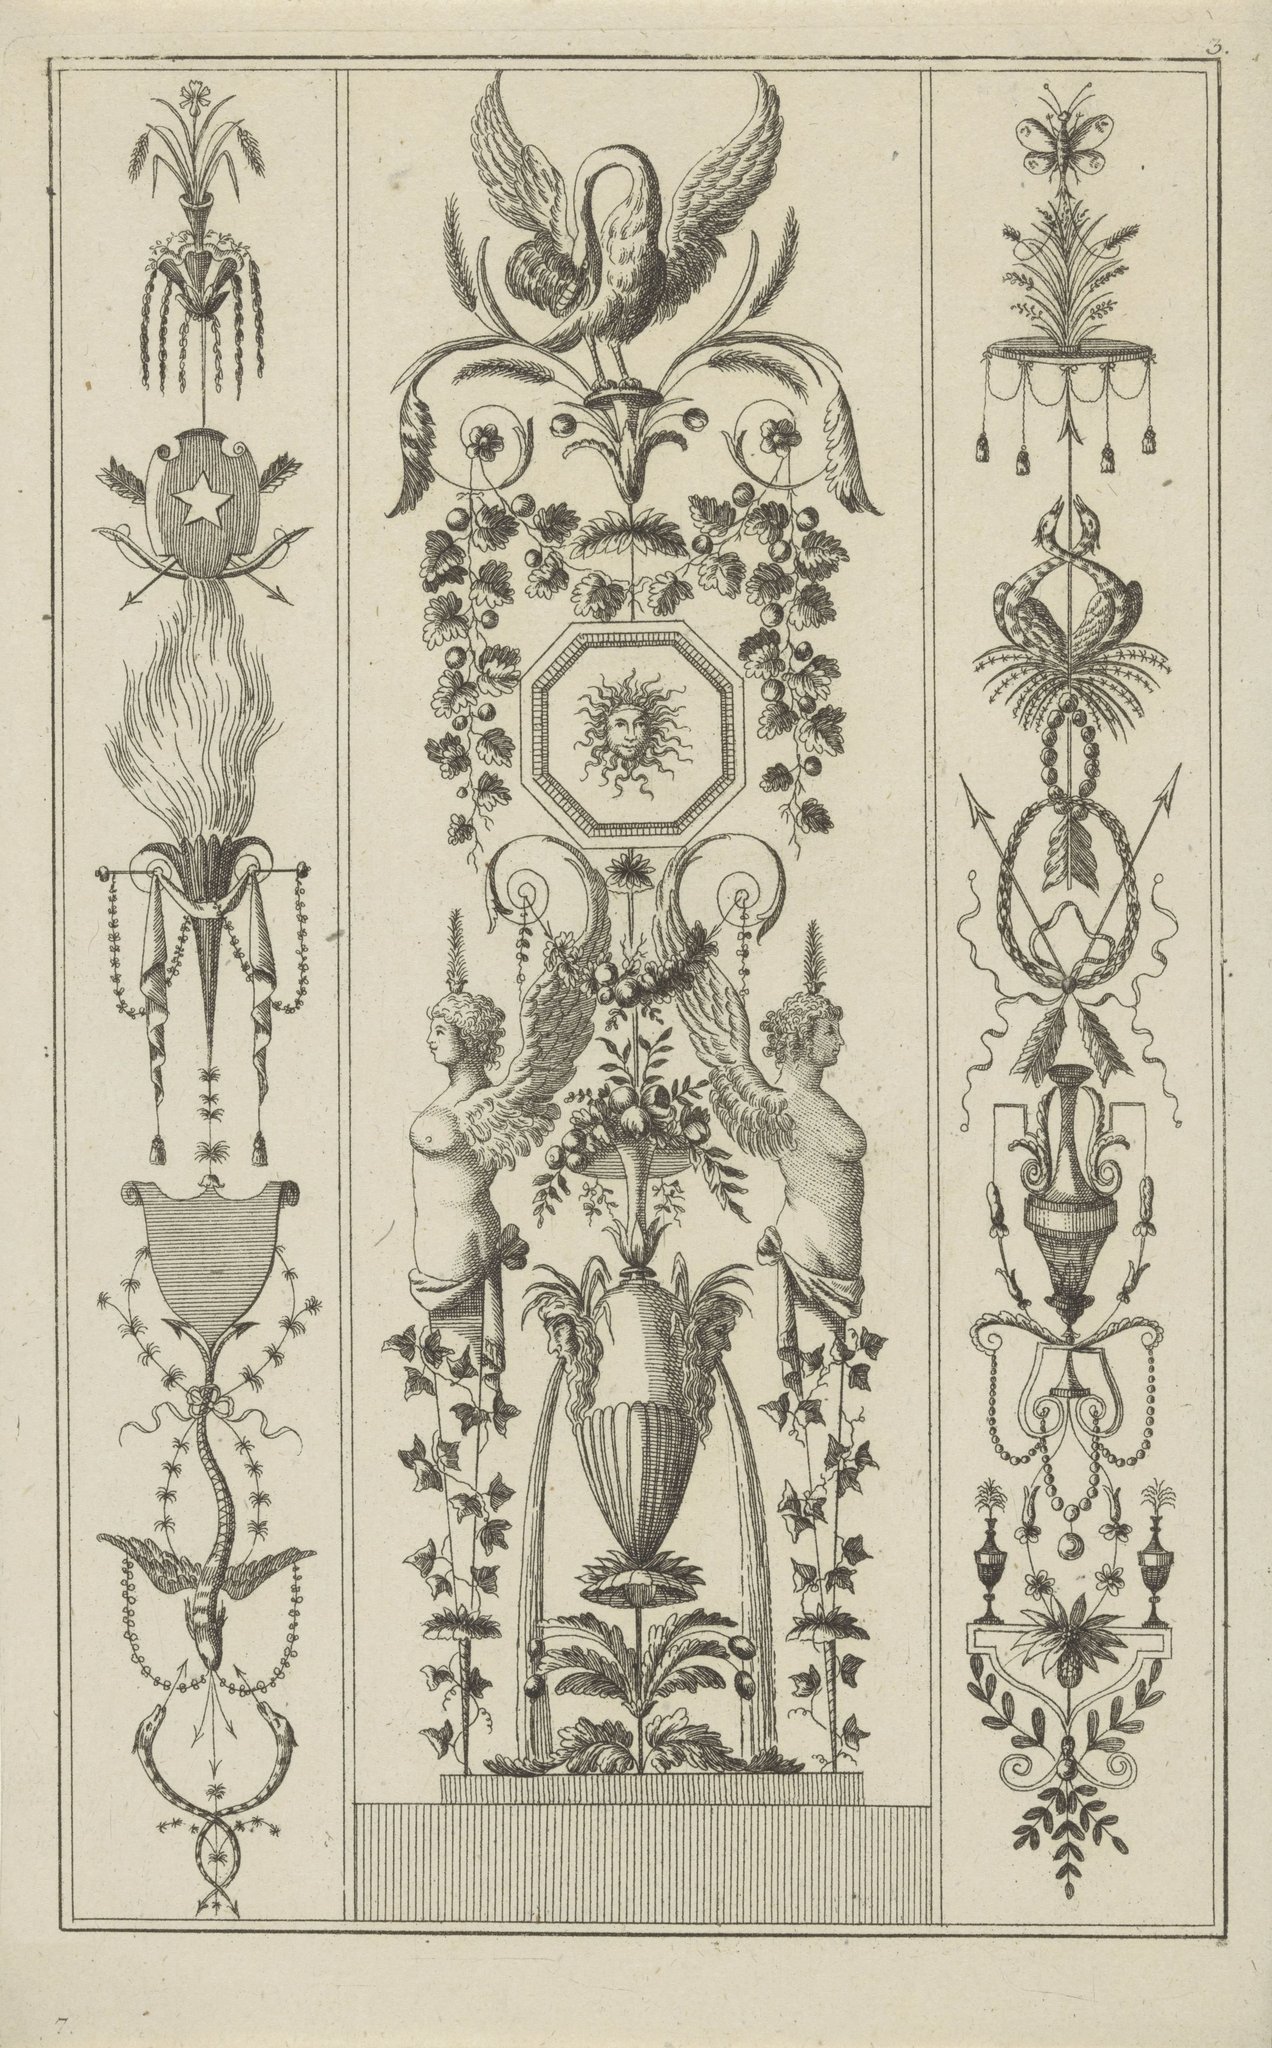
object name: print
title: Arabesken met gevleugelde vrouwen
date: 1780-1830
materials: paper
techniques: etching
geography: augsburg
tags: fabulous beings with wings - aa - female human figure, ornament ~ arabesque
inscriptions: collector's mark: Lugt 2228, collector's mark: Lugt 2760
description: Drie pilasters arabeskontwerpen met speren, een zwaan, een medaillon, twee gevleugelde vrouwfiguren en een fontein.